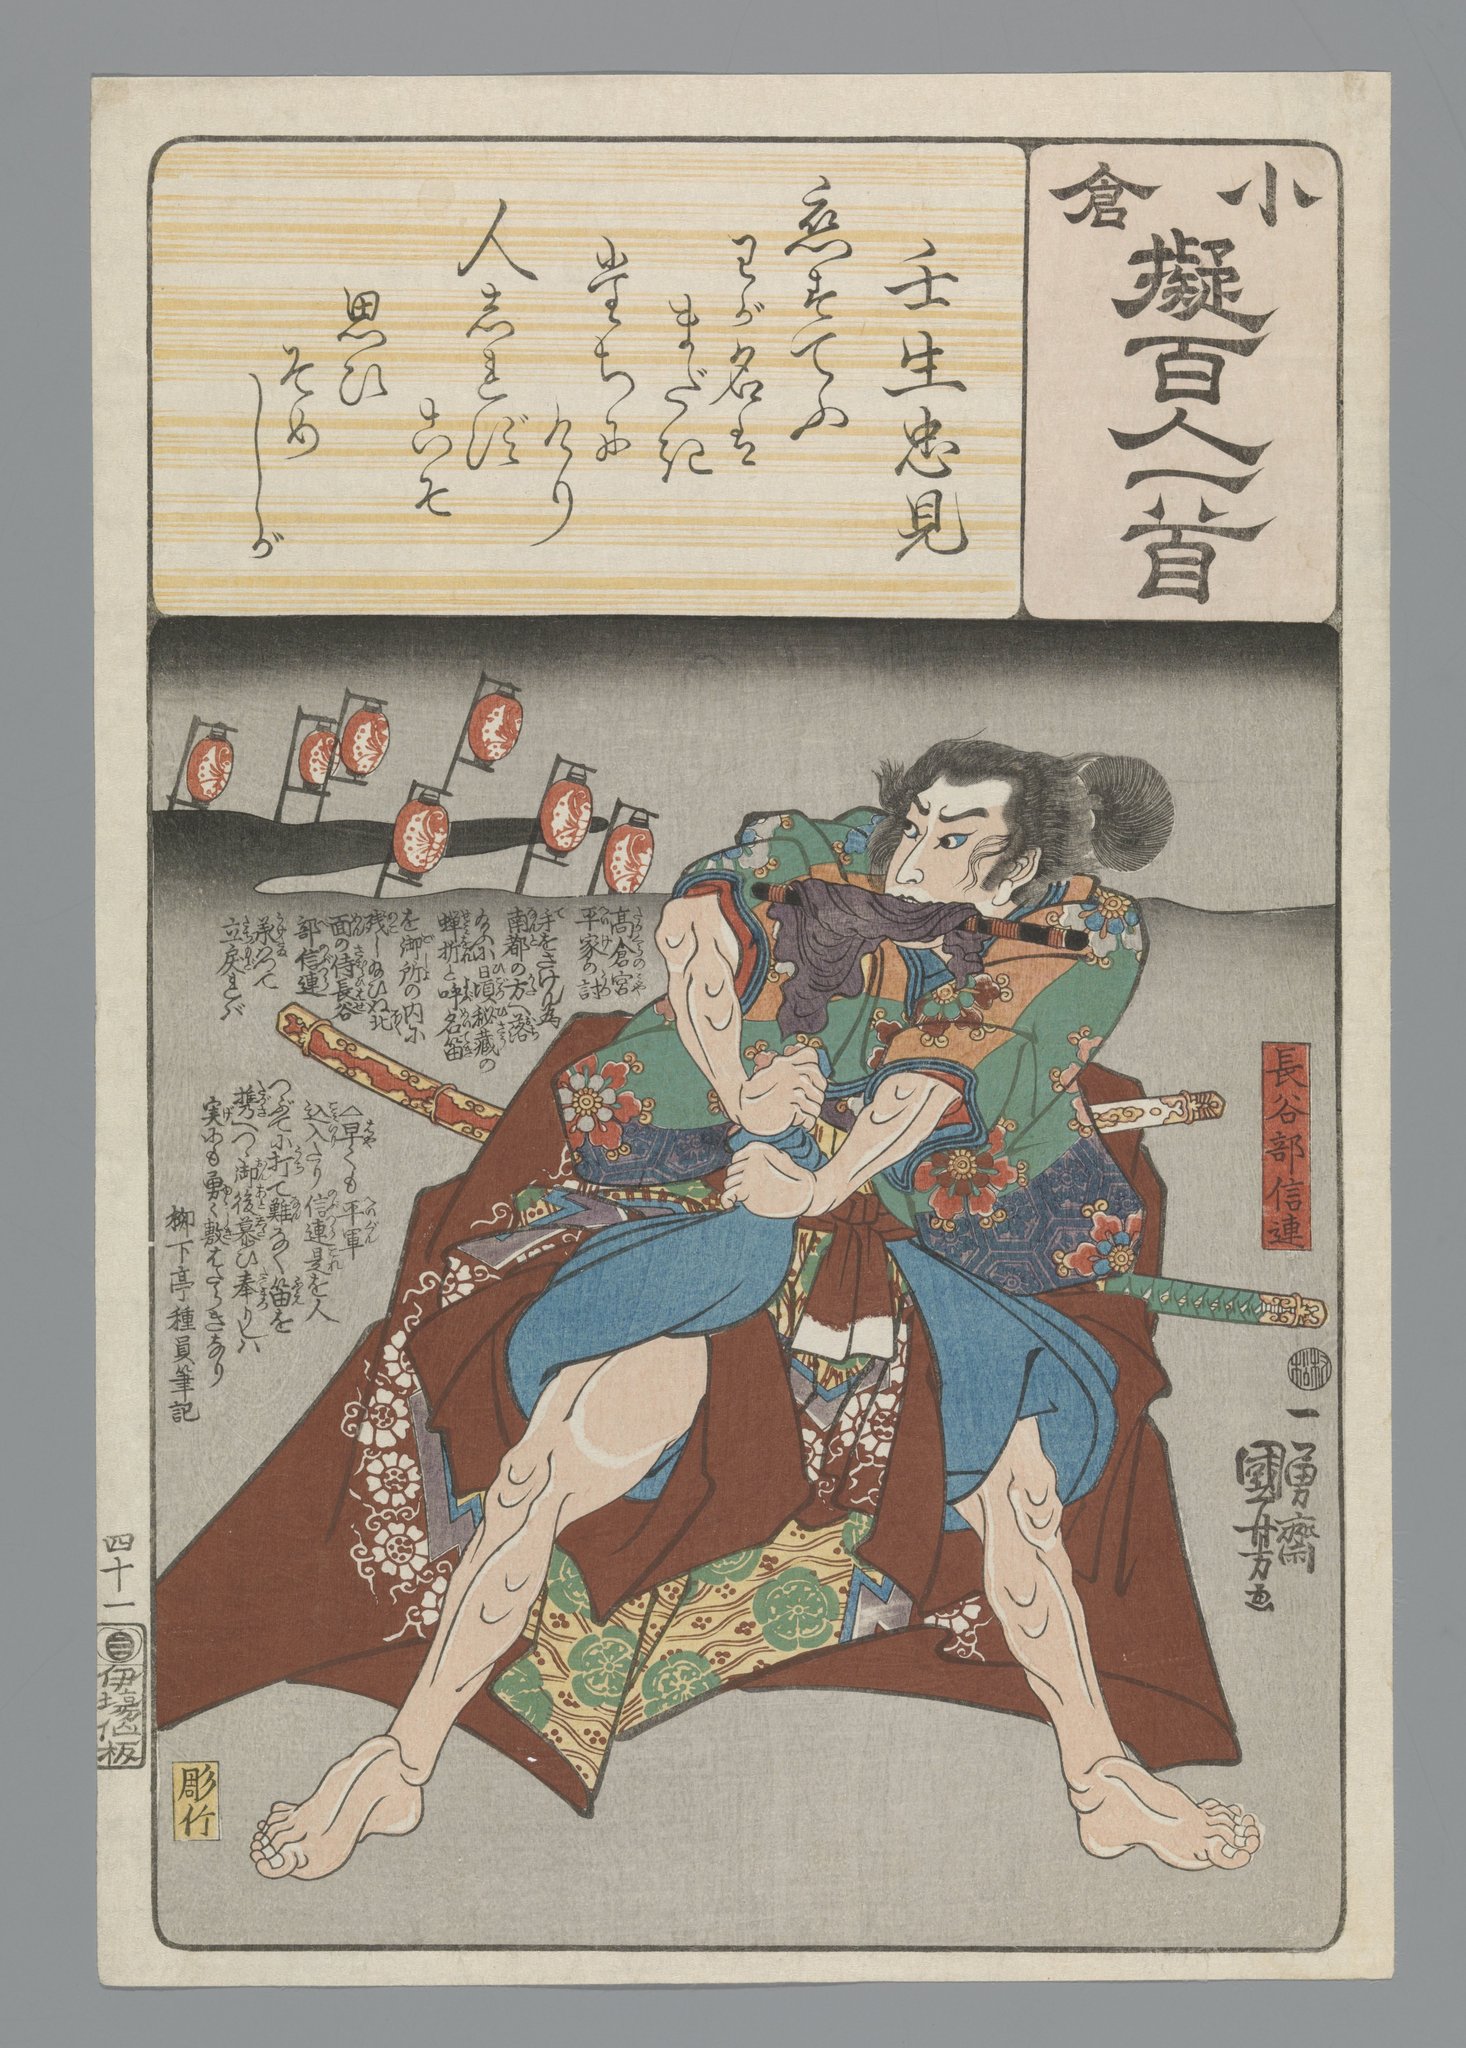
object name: print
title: Ogura Imitation of the One Hundred Poems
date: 1843-1846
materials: paper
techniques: woodcut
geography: japan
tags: carrying something, flight, running away; pursuing, lantern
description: Samurai Hasebe Nobutsura, knoopt z`n onderkleding op, terwijl hij omkijkt naar de aanvallende troepen, waarvan alleen de lantaarnen zijn afgebeeld. In zijn mond heeft hij de in een paarse doek gewikkelde lievelingsfluit van zijn meester, prins Mochihito. De witte gestileerde vlinder op de rode lantaarnen is het familiewapen van de Taira clan. Scene uit een kabukitoneelstuk. Gedicht door Mibu no Tadami.